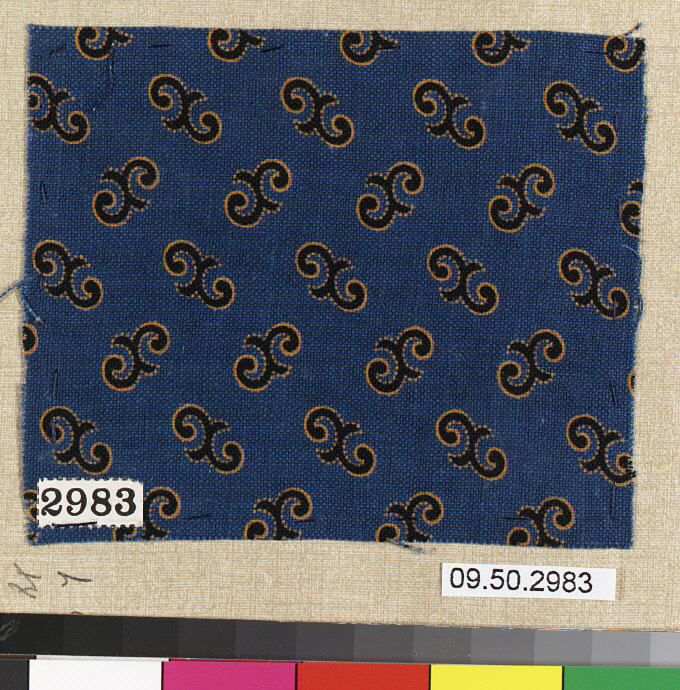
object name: piece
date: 1801-1900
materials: cotton